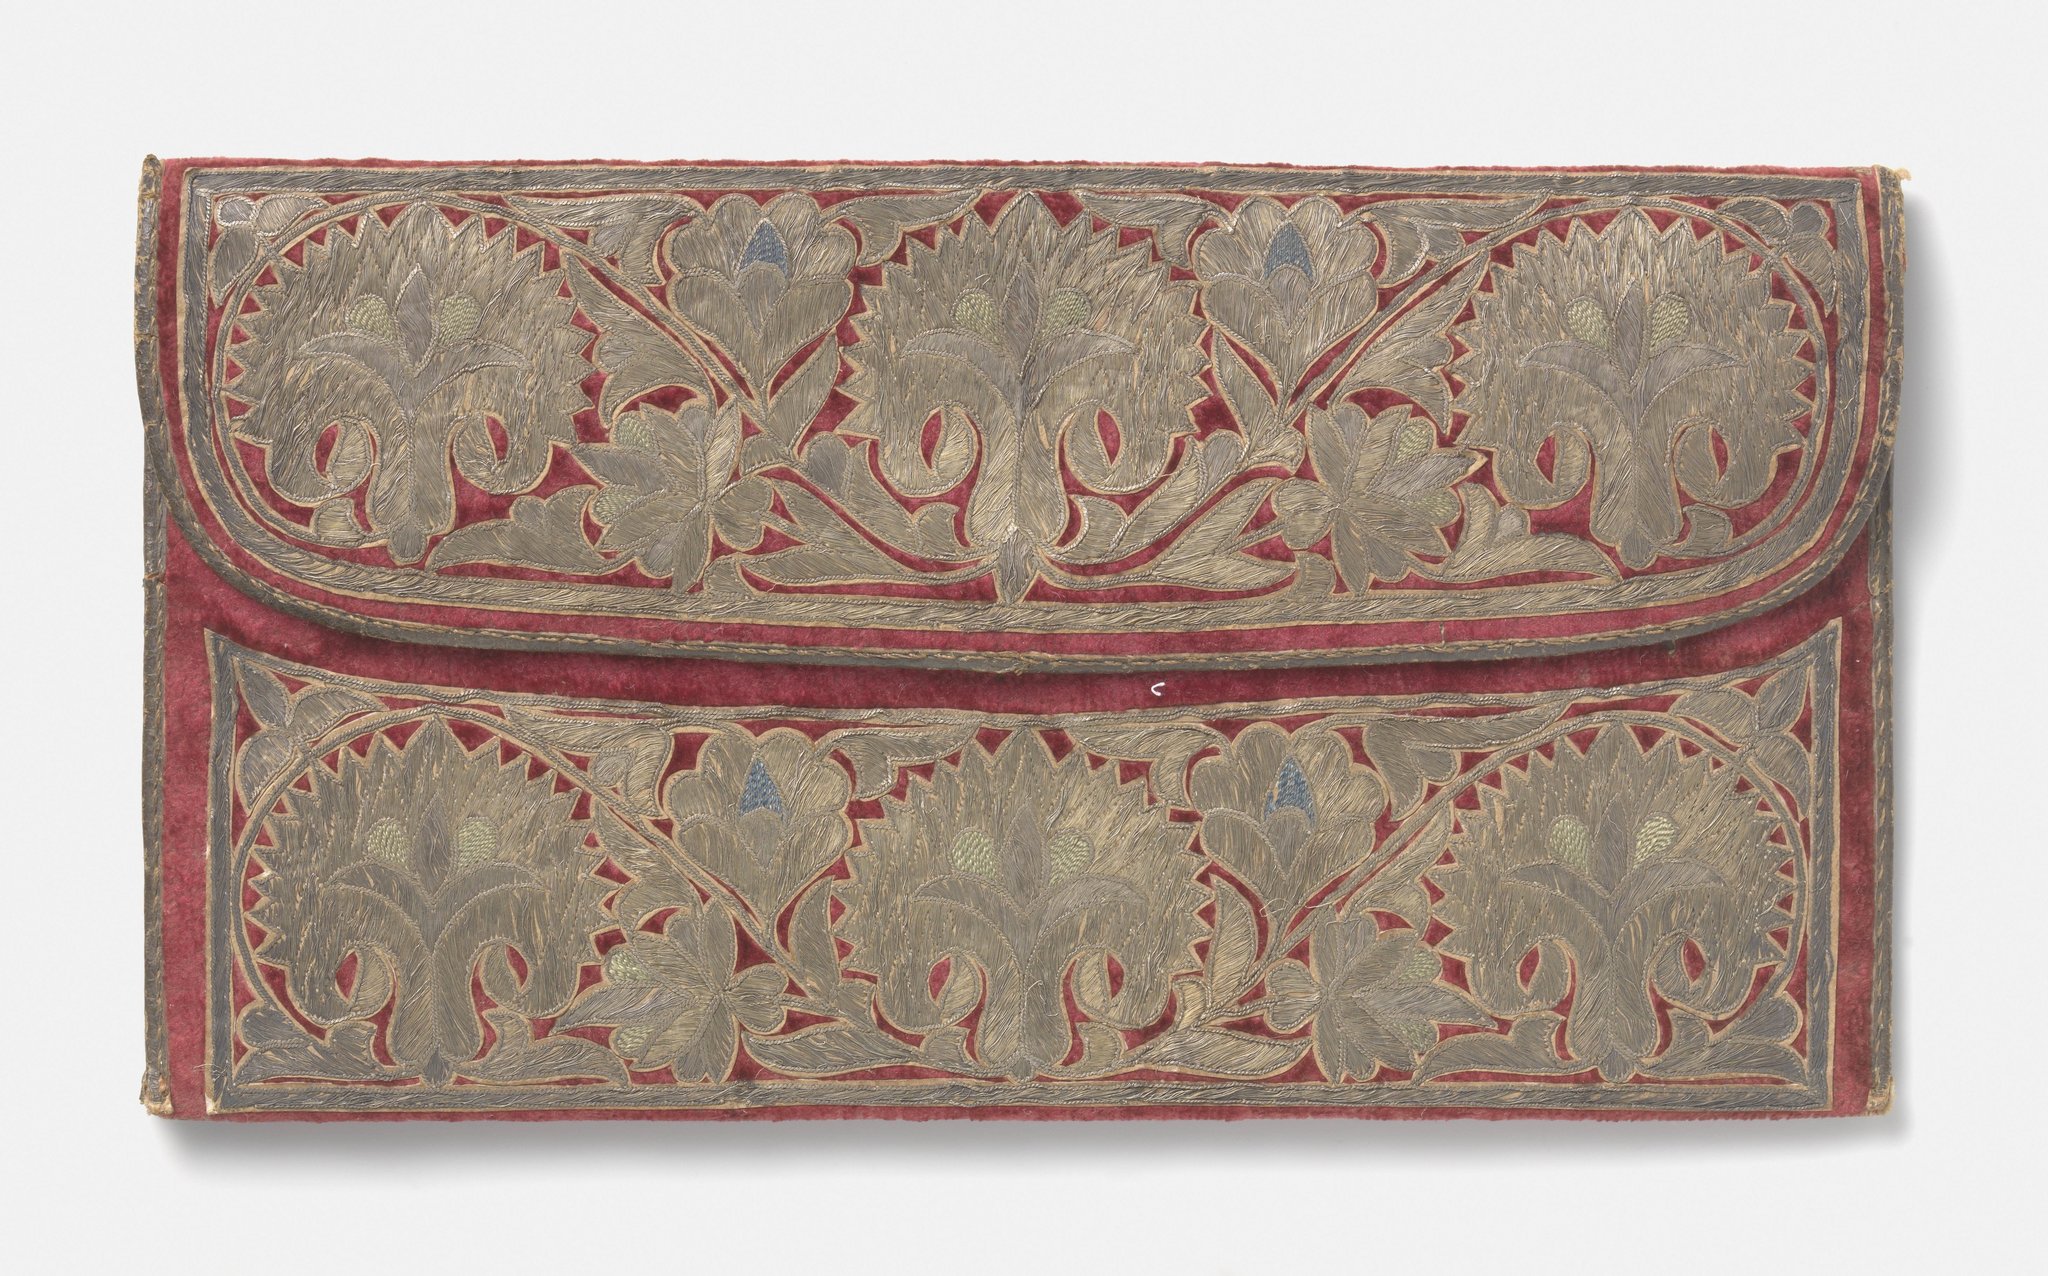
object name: brieventas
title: Tas in een plat, rechthoekigmodel, van rood fluweel waarop borduursel in goud- en zilverdraad het opschrift 'Francois Louis Vander Wiellen' en 'Constantinopoli 1696'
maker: Anonymous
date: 1696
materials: leather, gold thread, linen, silk, thread, velvet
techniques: cutting, embroidered, weave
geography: constantinople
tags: francois louis van der wiellen, constantinopel, istanboel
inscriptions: date letter: ‘'1696'’, name: ‘'Francois Louis Vander/Wiellen'’, address: ‘'Constantinopoli'’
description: Brieventas in een plat, rechthoekigmodel van rood fluweel. Voor- en achterkant zijn bijna volledig versierd met borduursel in goud- en zilverdraad met kleine details in blauwe zijde. Onder de klep aan de voorkant is het opschrift 'Francois Louis Vander Wiellen' geborduurd. Op de achterkant staat in gekrulde letters 'Constantinopoli 1696'. De voering van de tas is van linnen.